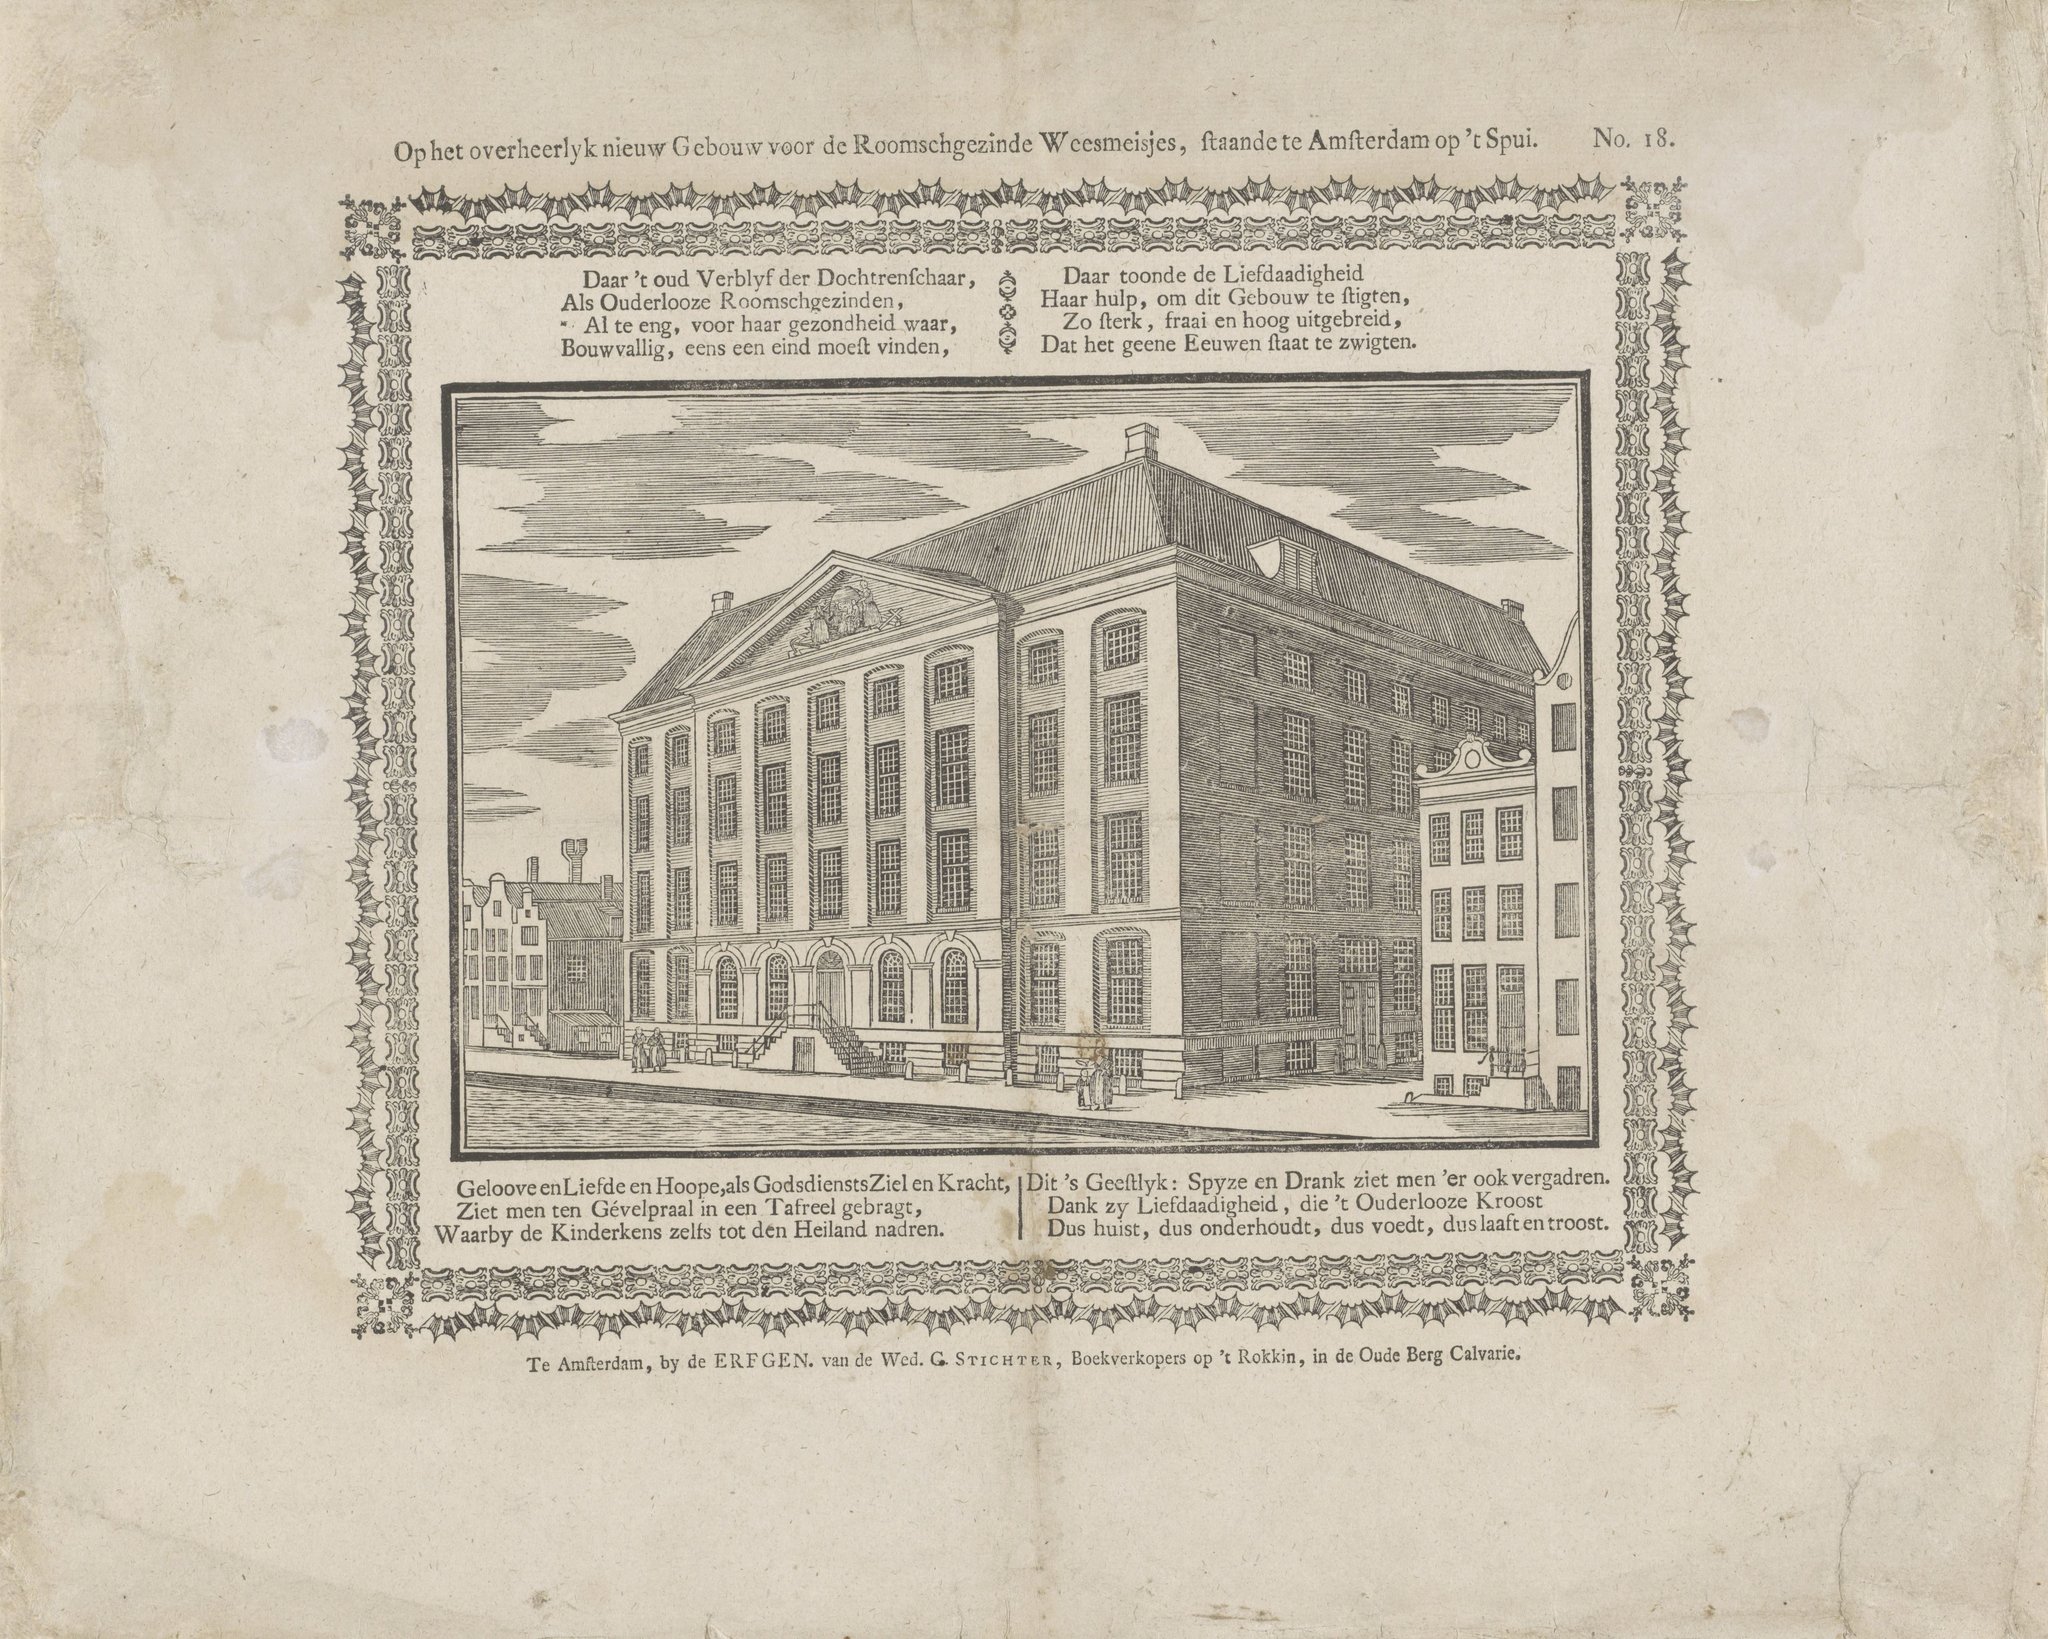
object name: popular print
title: Op het overheerlyk nieuw gebouw voor de roomschgezinde weesmeisjes, staande te Amsterdam op 't Spui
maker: Anonymous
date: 1715-1813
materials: paper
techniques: letterpress printing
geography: netherlands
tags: orphanage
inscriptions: collector's mark: Lugt 2760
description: Blad met een grote voorstelling van het Maagdenhuis aan het Spui te Amsterdam. Boven en onder de afbeelding versregels. Genummerd rechtsboven: No. 18.